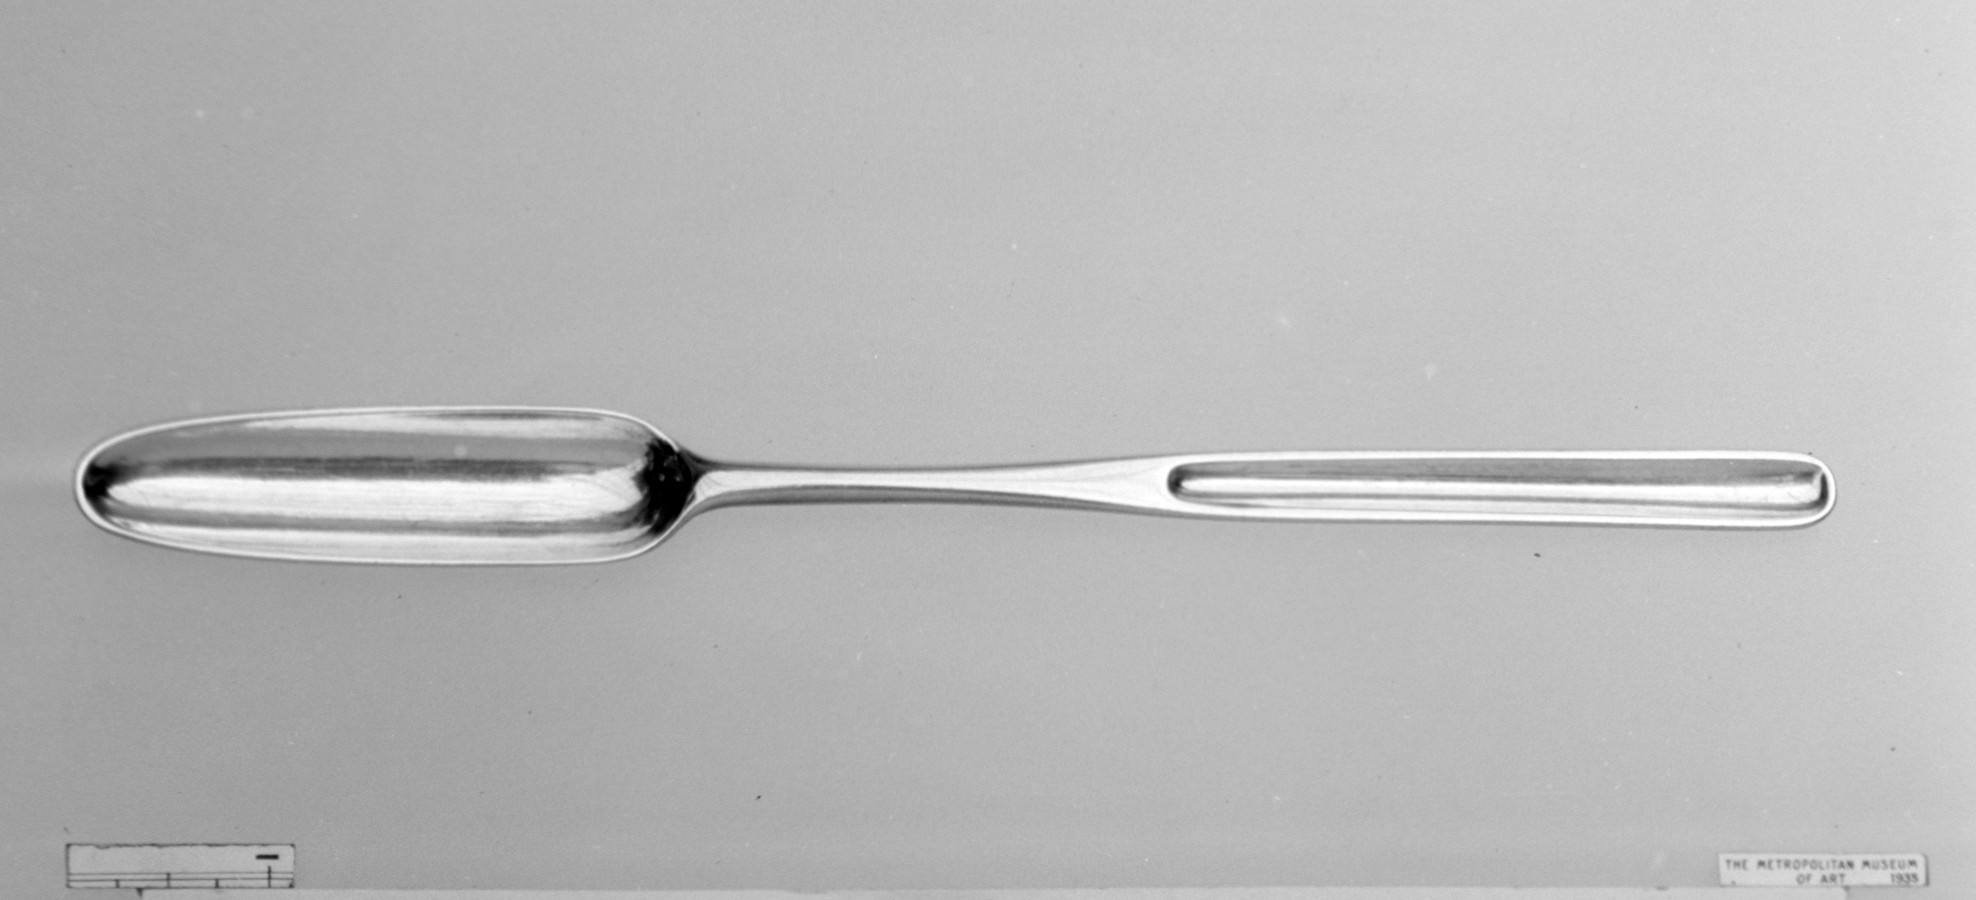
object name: marrow scoop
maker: william watkins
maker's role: maker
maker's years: 1756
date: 1762-1763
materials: silver